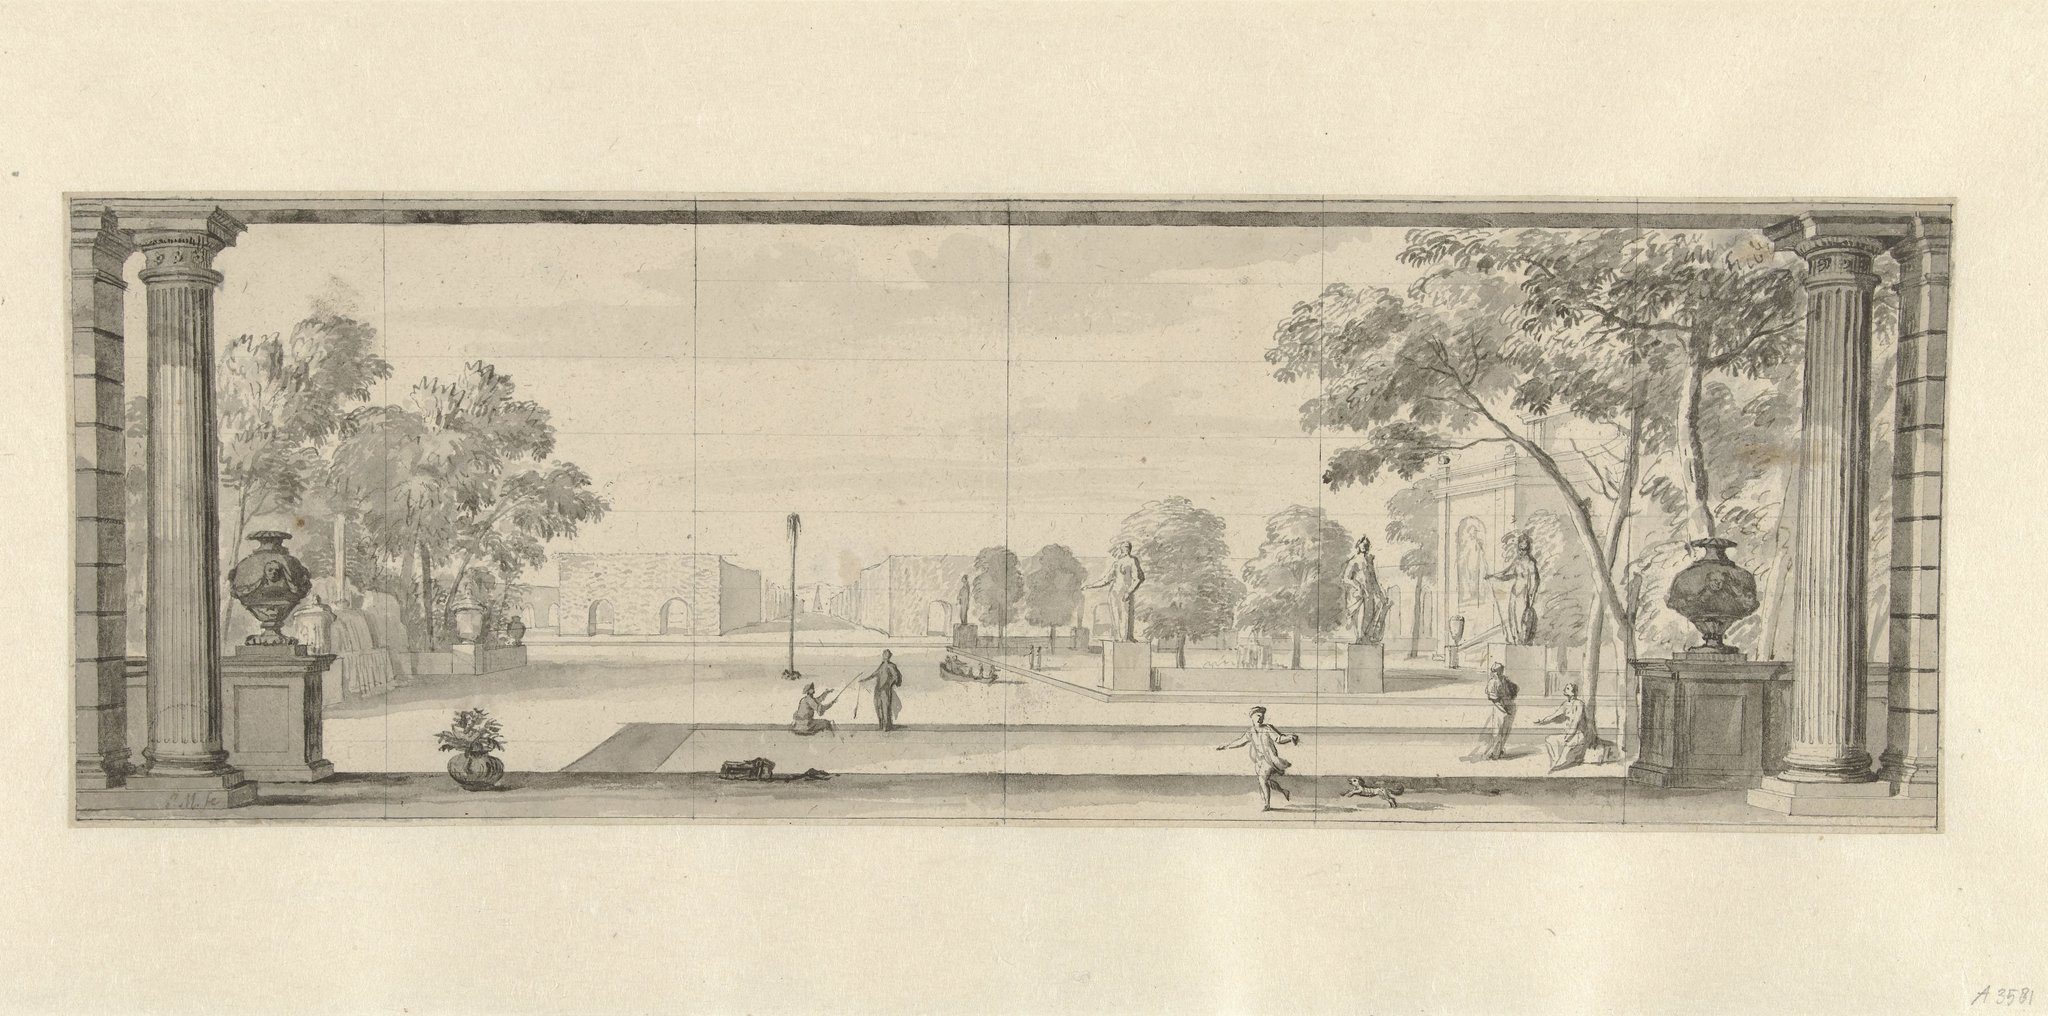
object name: design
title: Ontwerp voor een kamerbehangsel met gezicht in een park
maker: Anonymous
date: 1700-1800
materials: ink, paper, pencil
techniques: brush, pen, drawing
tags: wall-covering